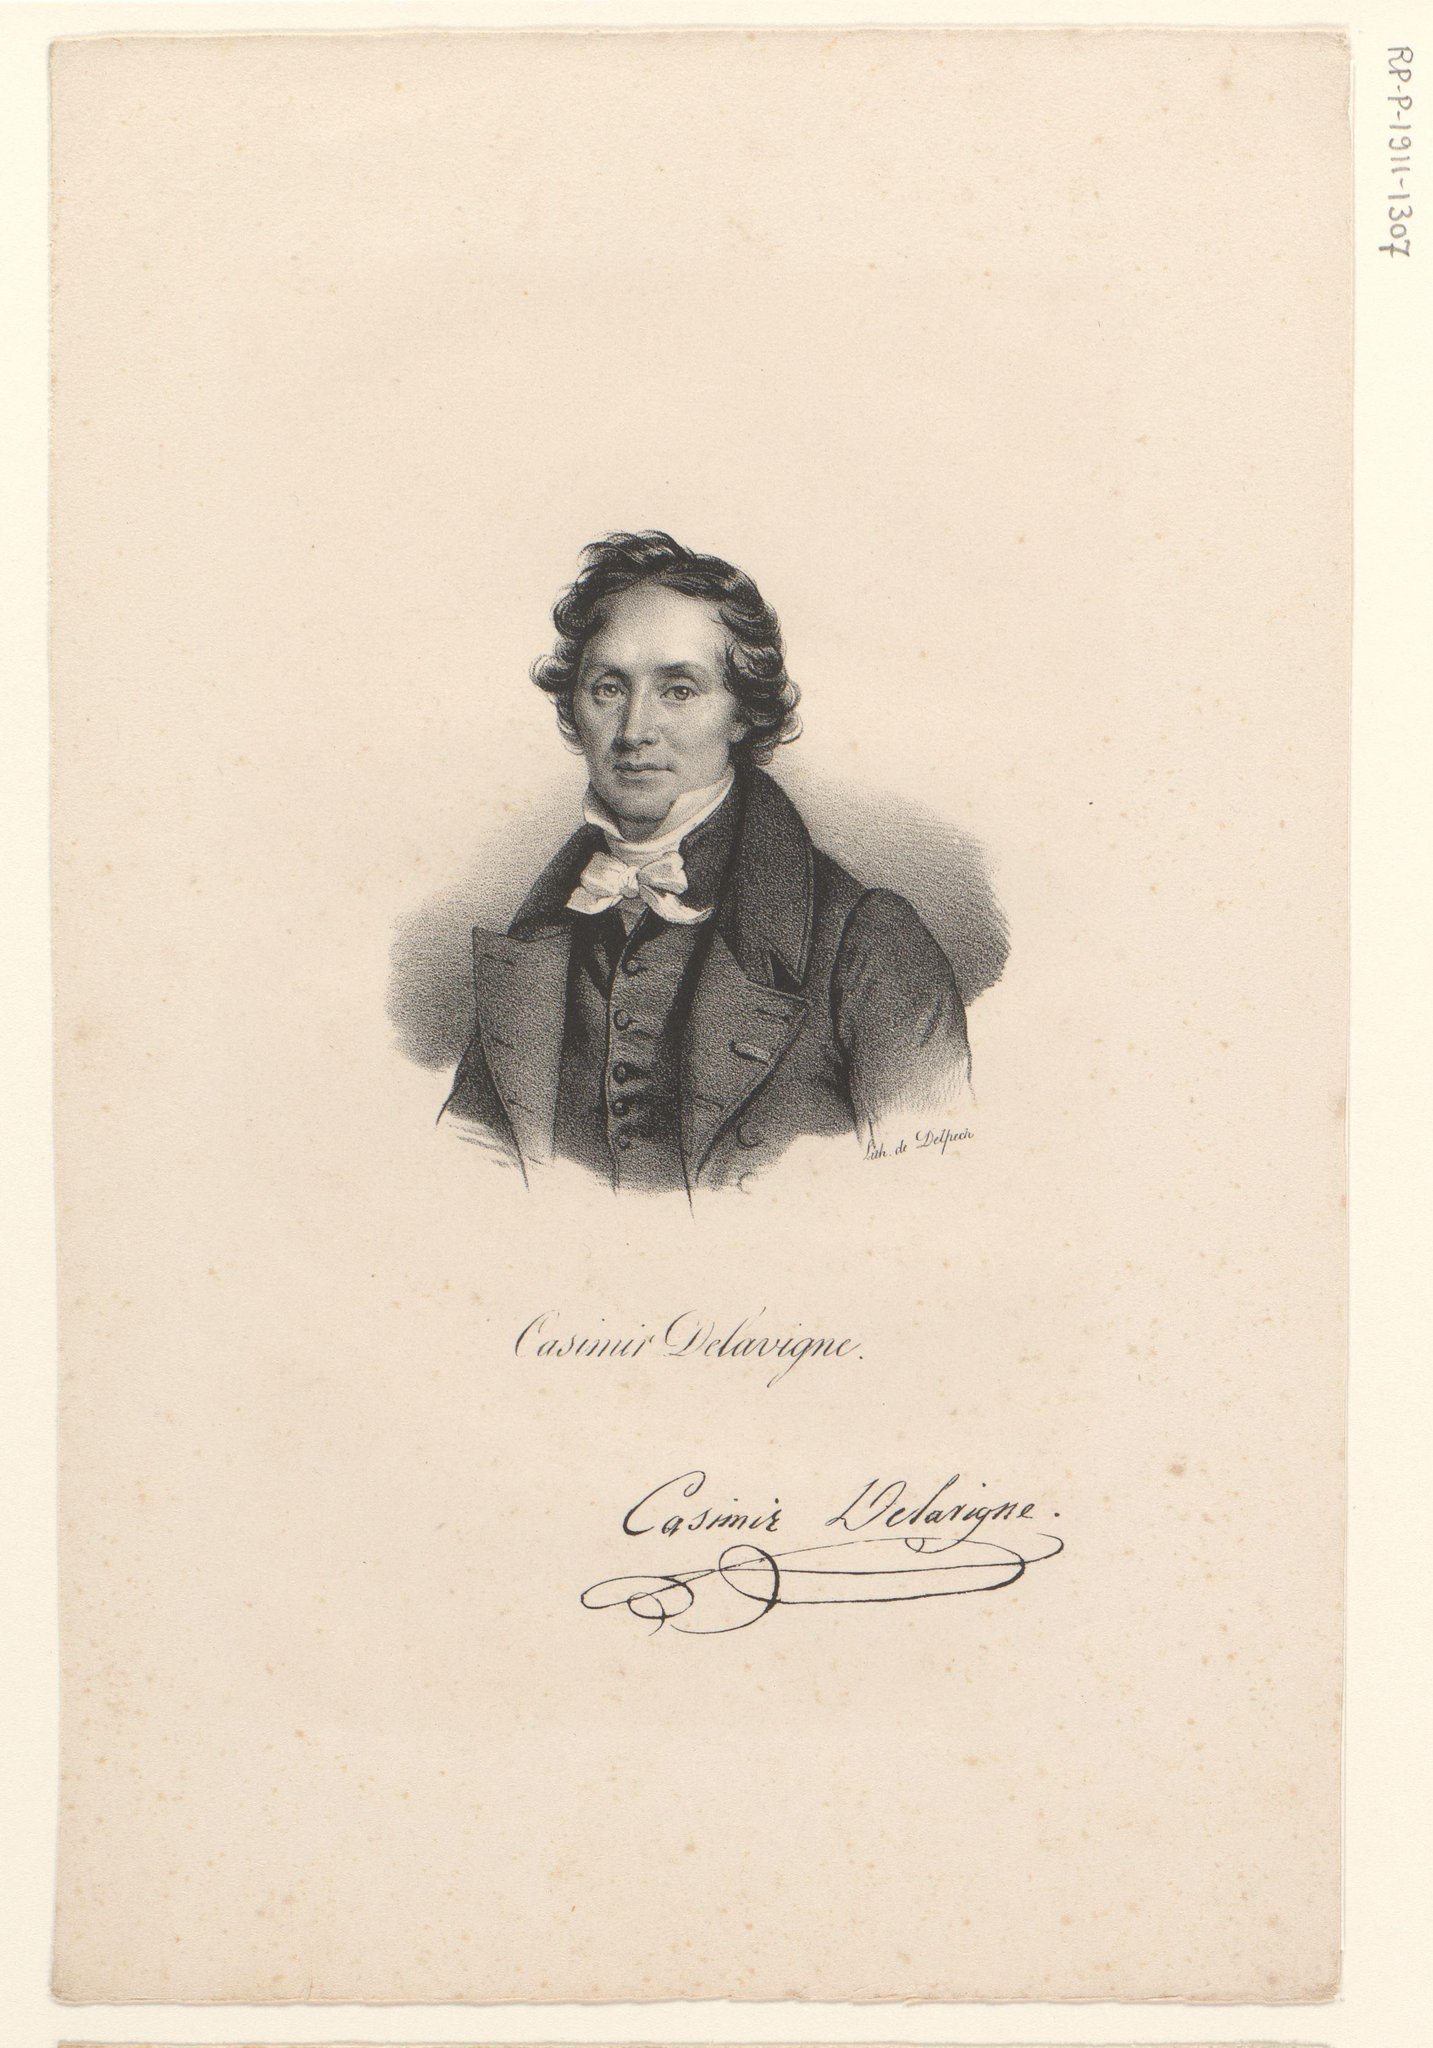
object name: print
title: Portret van Casimir Delavigne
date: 1818-1842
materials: paper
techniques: lithograph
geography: paris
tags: historical persons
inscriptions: collector's mark: Lugt 2228a